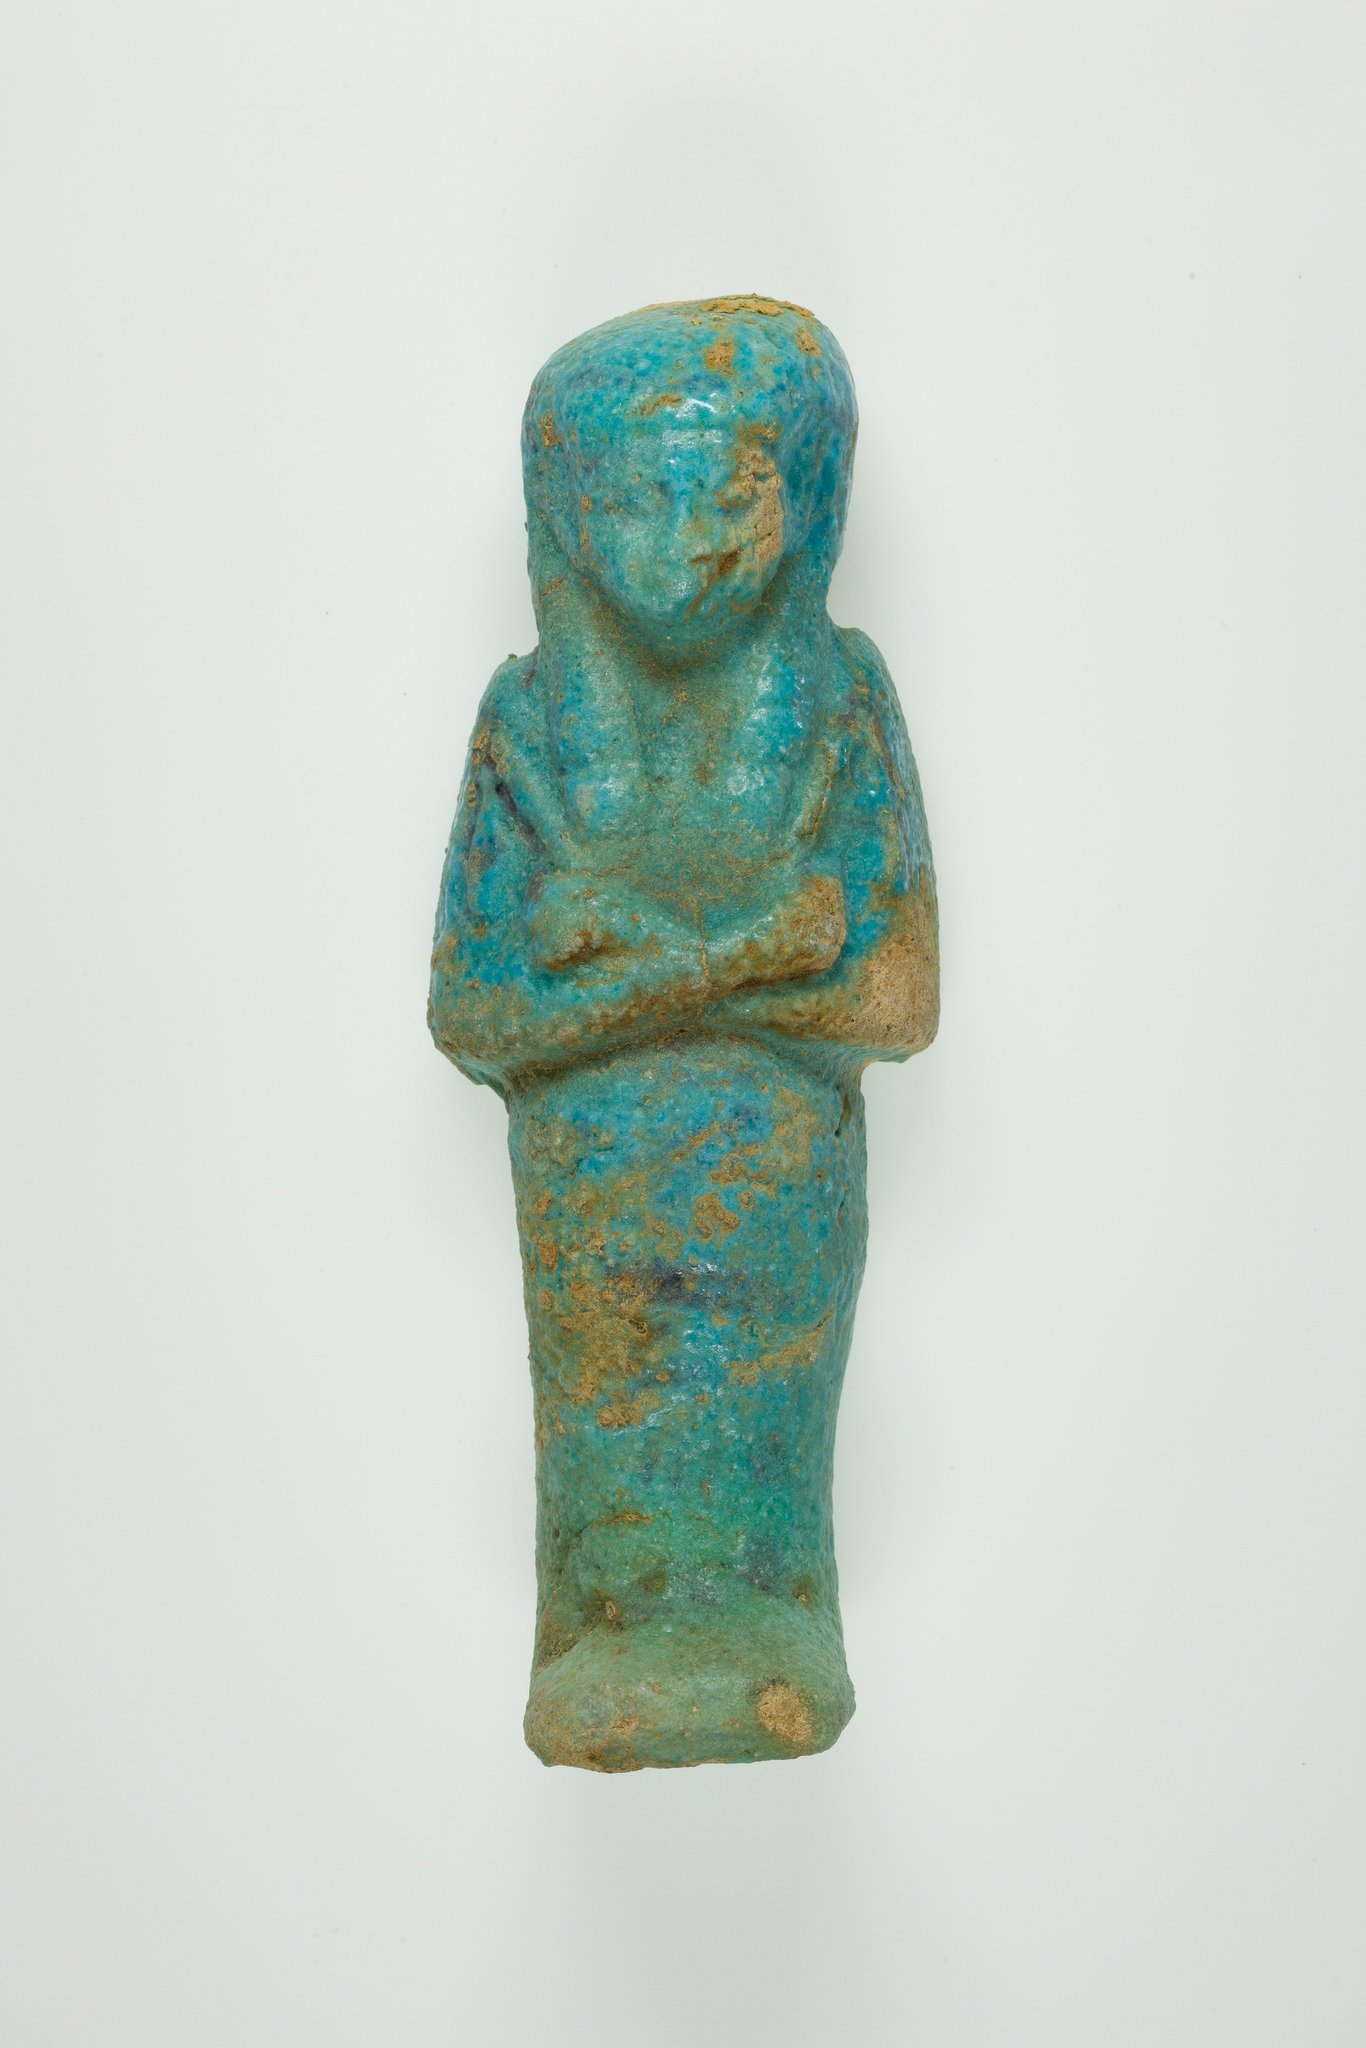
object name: worker shabti, henettawy c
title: Worker Shabti of Henettawy (C), Daughter of Isetemkheb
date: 990-970 BCE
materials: faience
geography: egypt